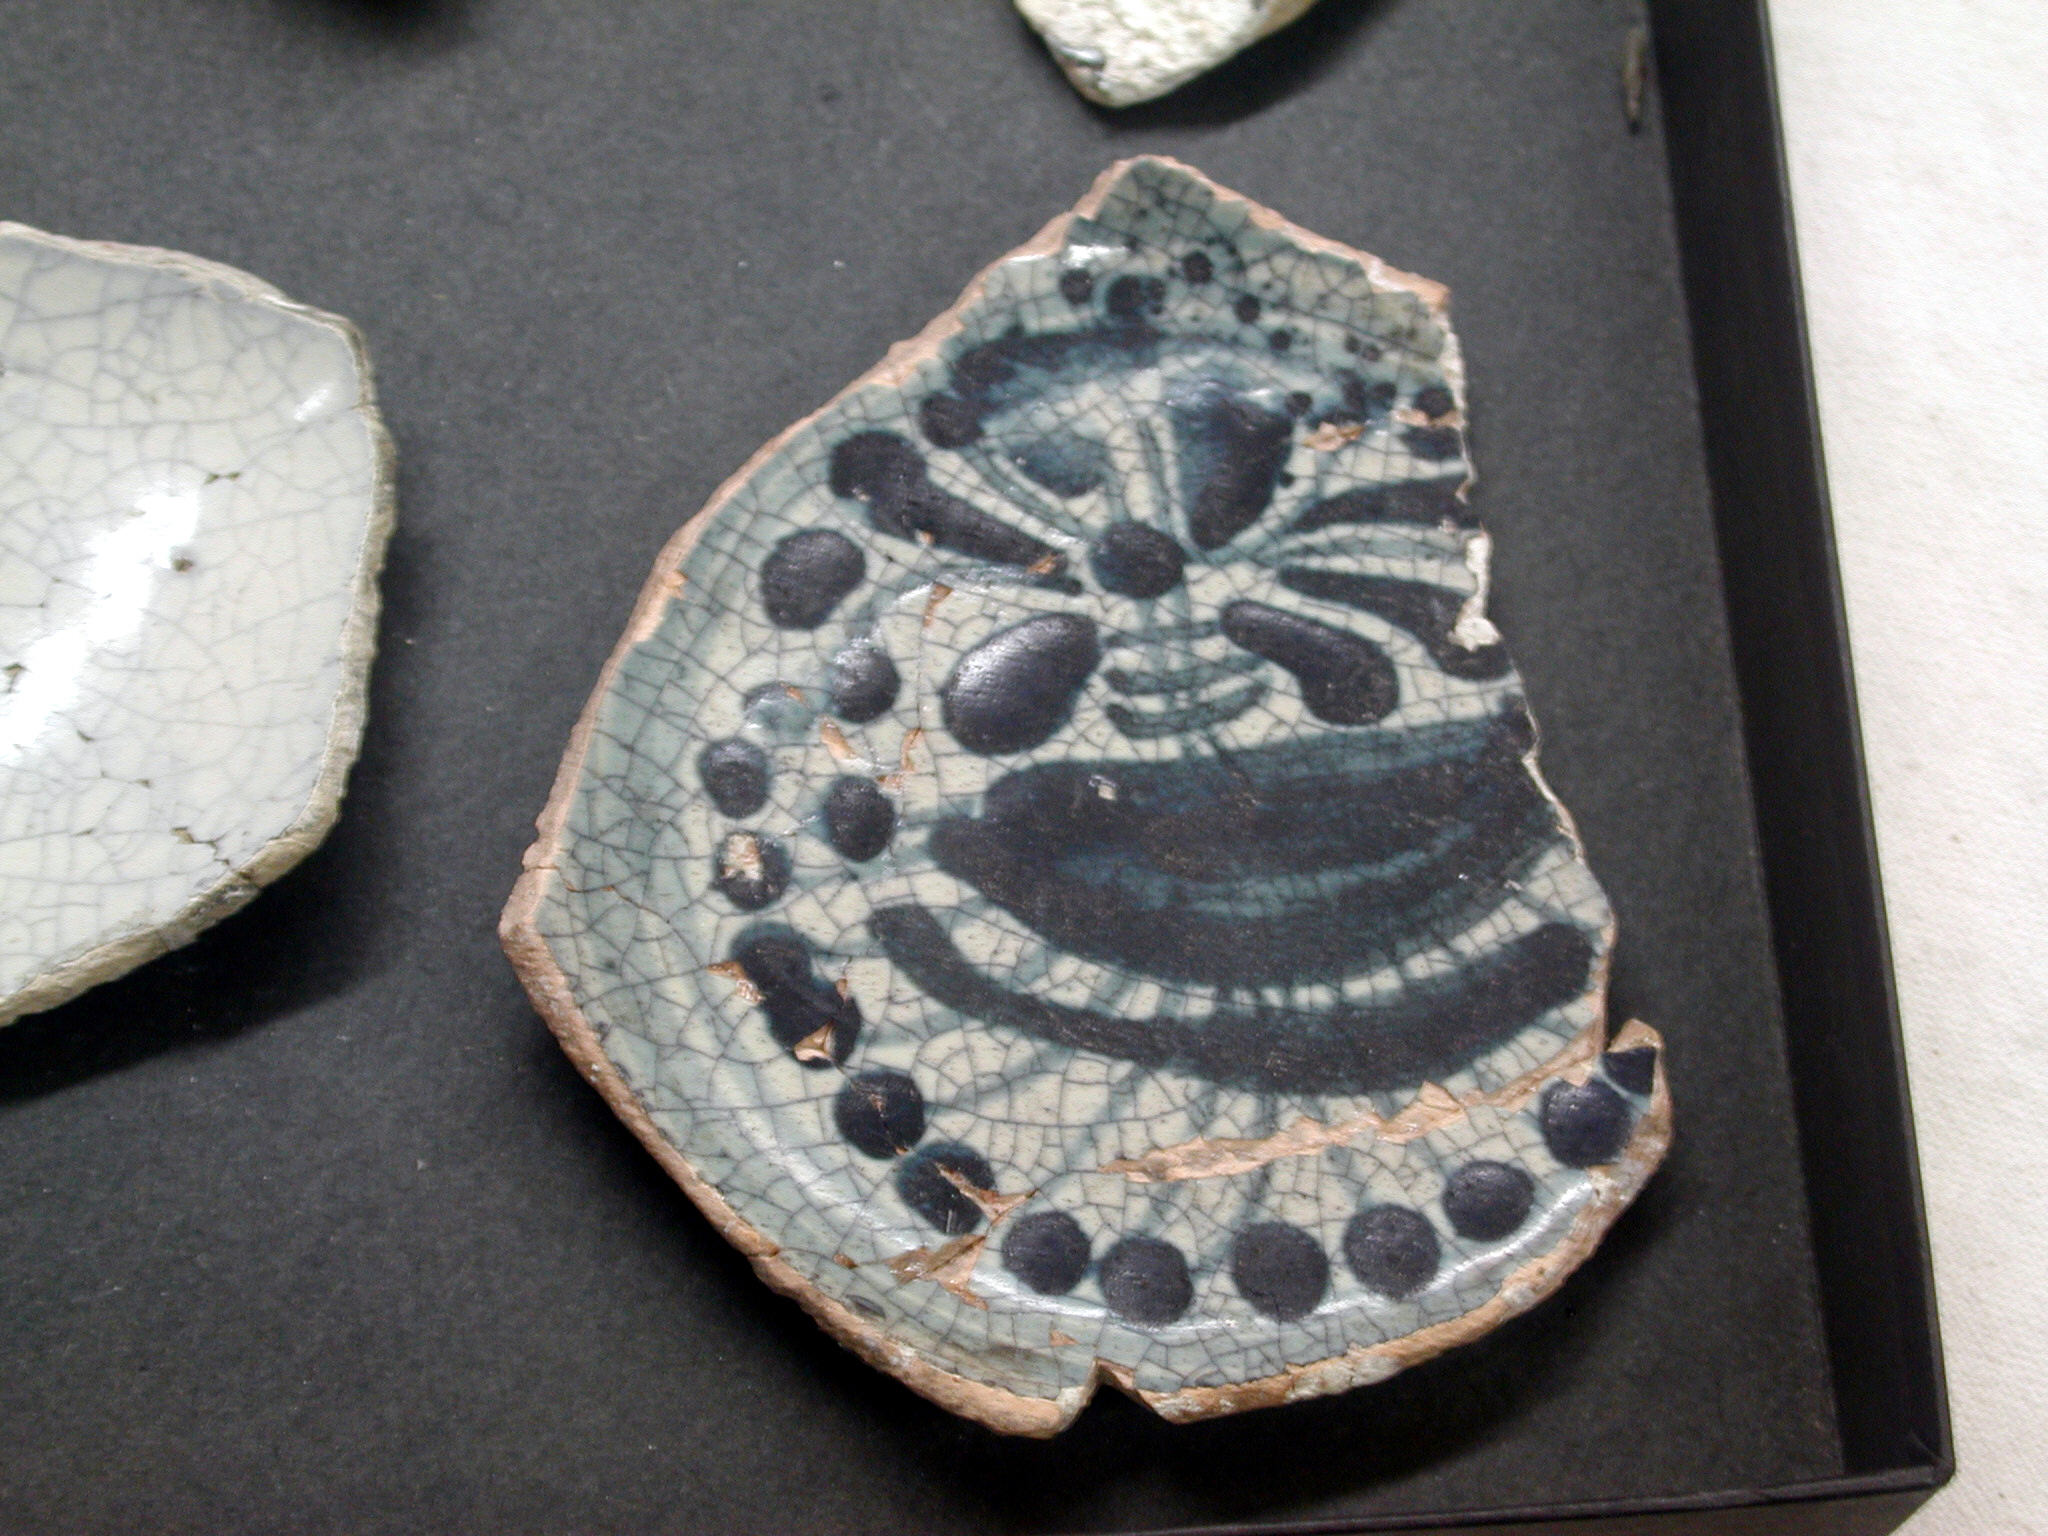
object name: fragment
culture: mexican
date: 1601-1650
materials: earthenware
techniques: glazing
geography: mexico